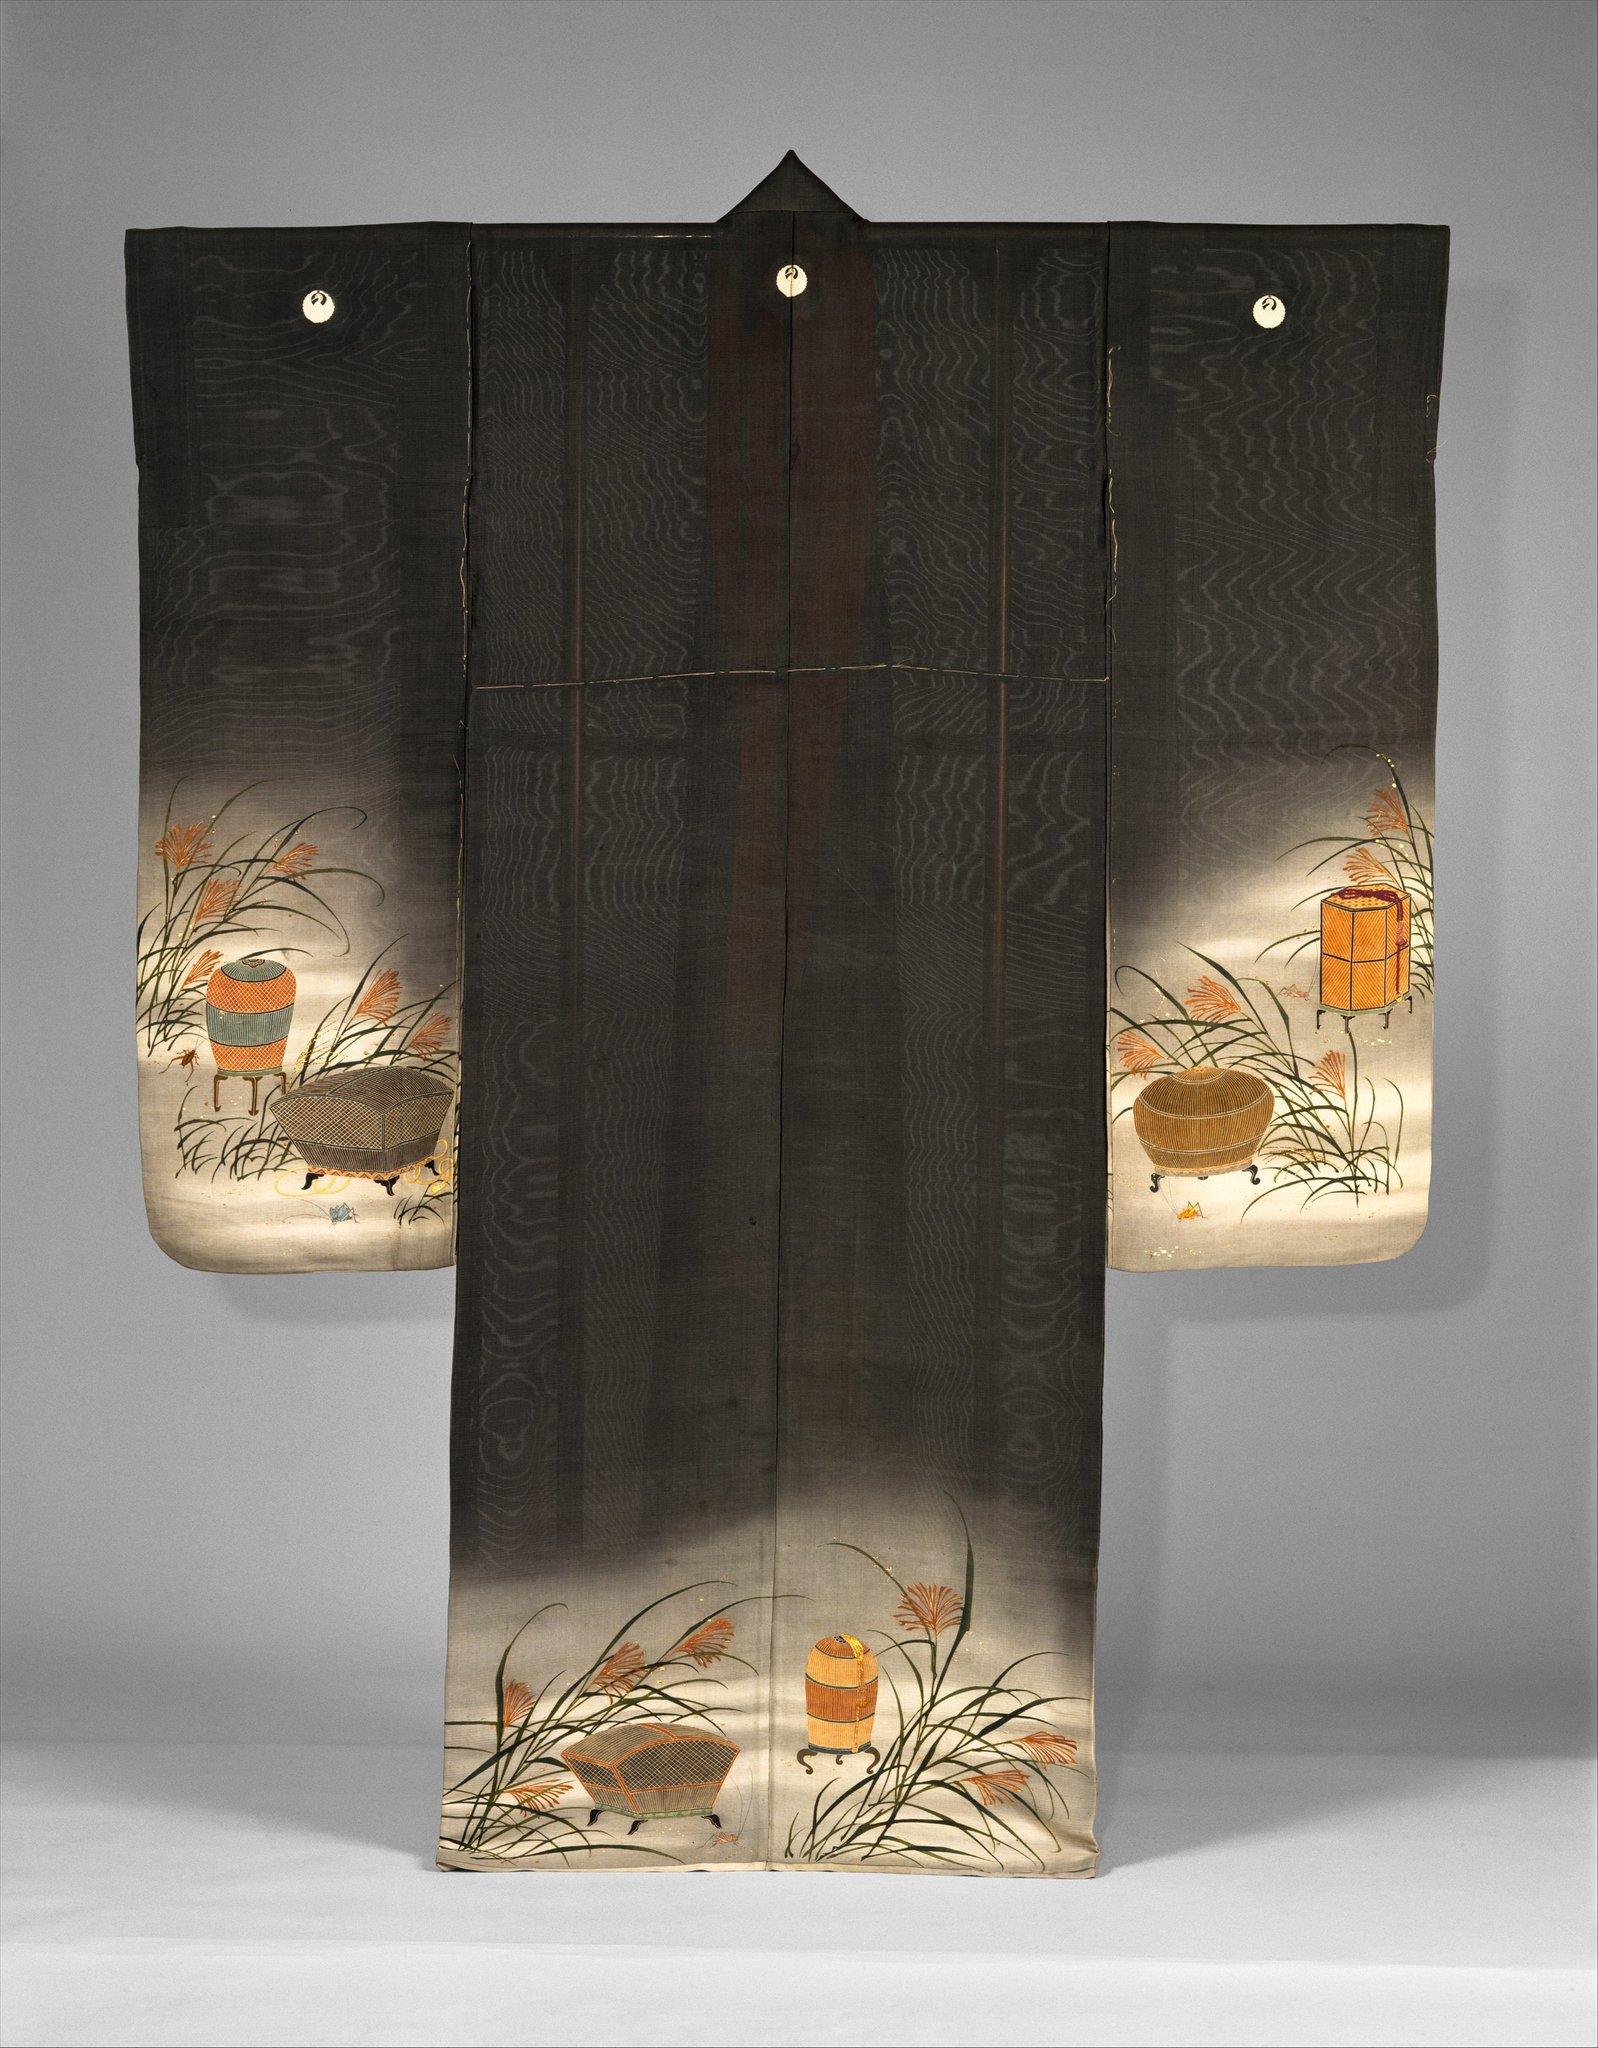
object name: summer kimono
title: Unlined Summer Kimono (Hito-e) with Crickets, Grasshoppers, Cricket Cages, and Pampas Grass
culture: japanese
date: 1901-1933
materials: textile, paste, silk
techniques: dyeing, embroidery, painting, resist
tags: plants